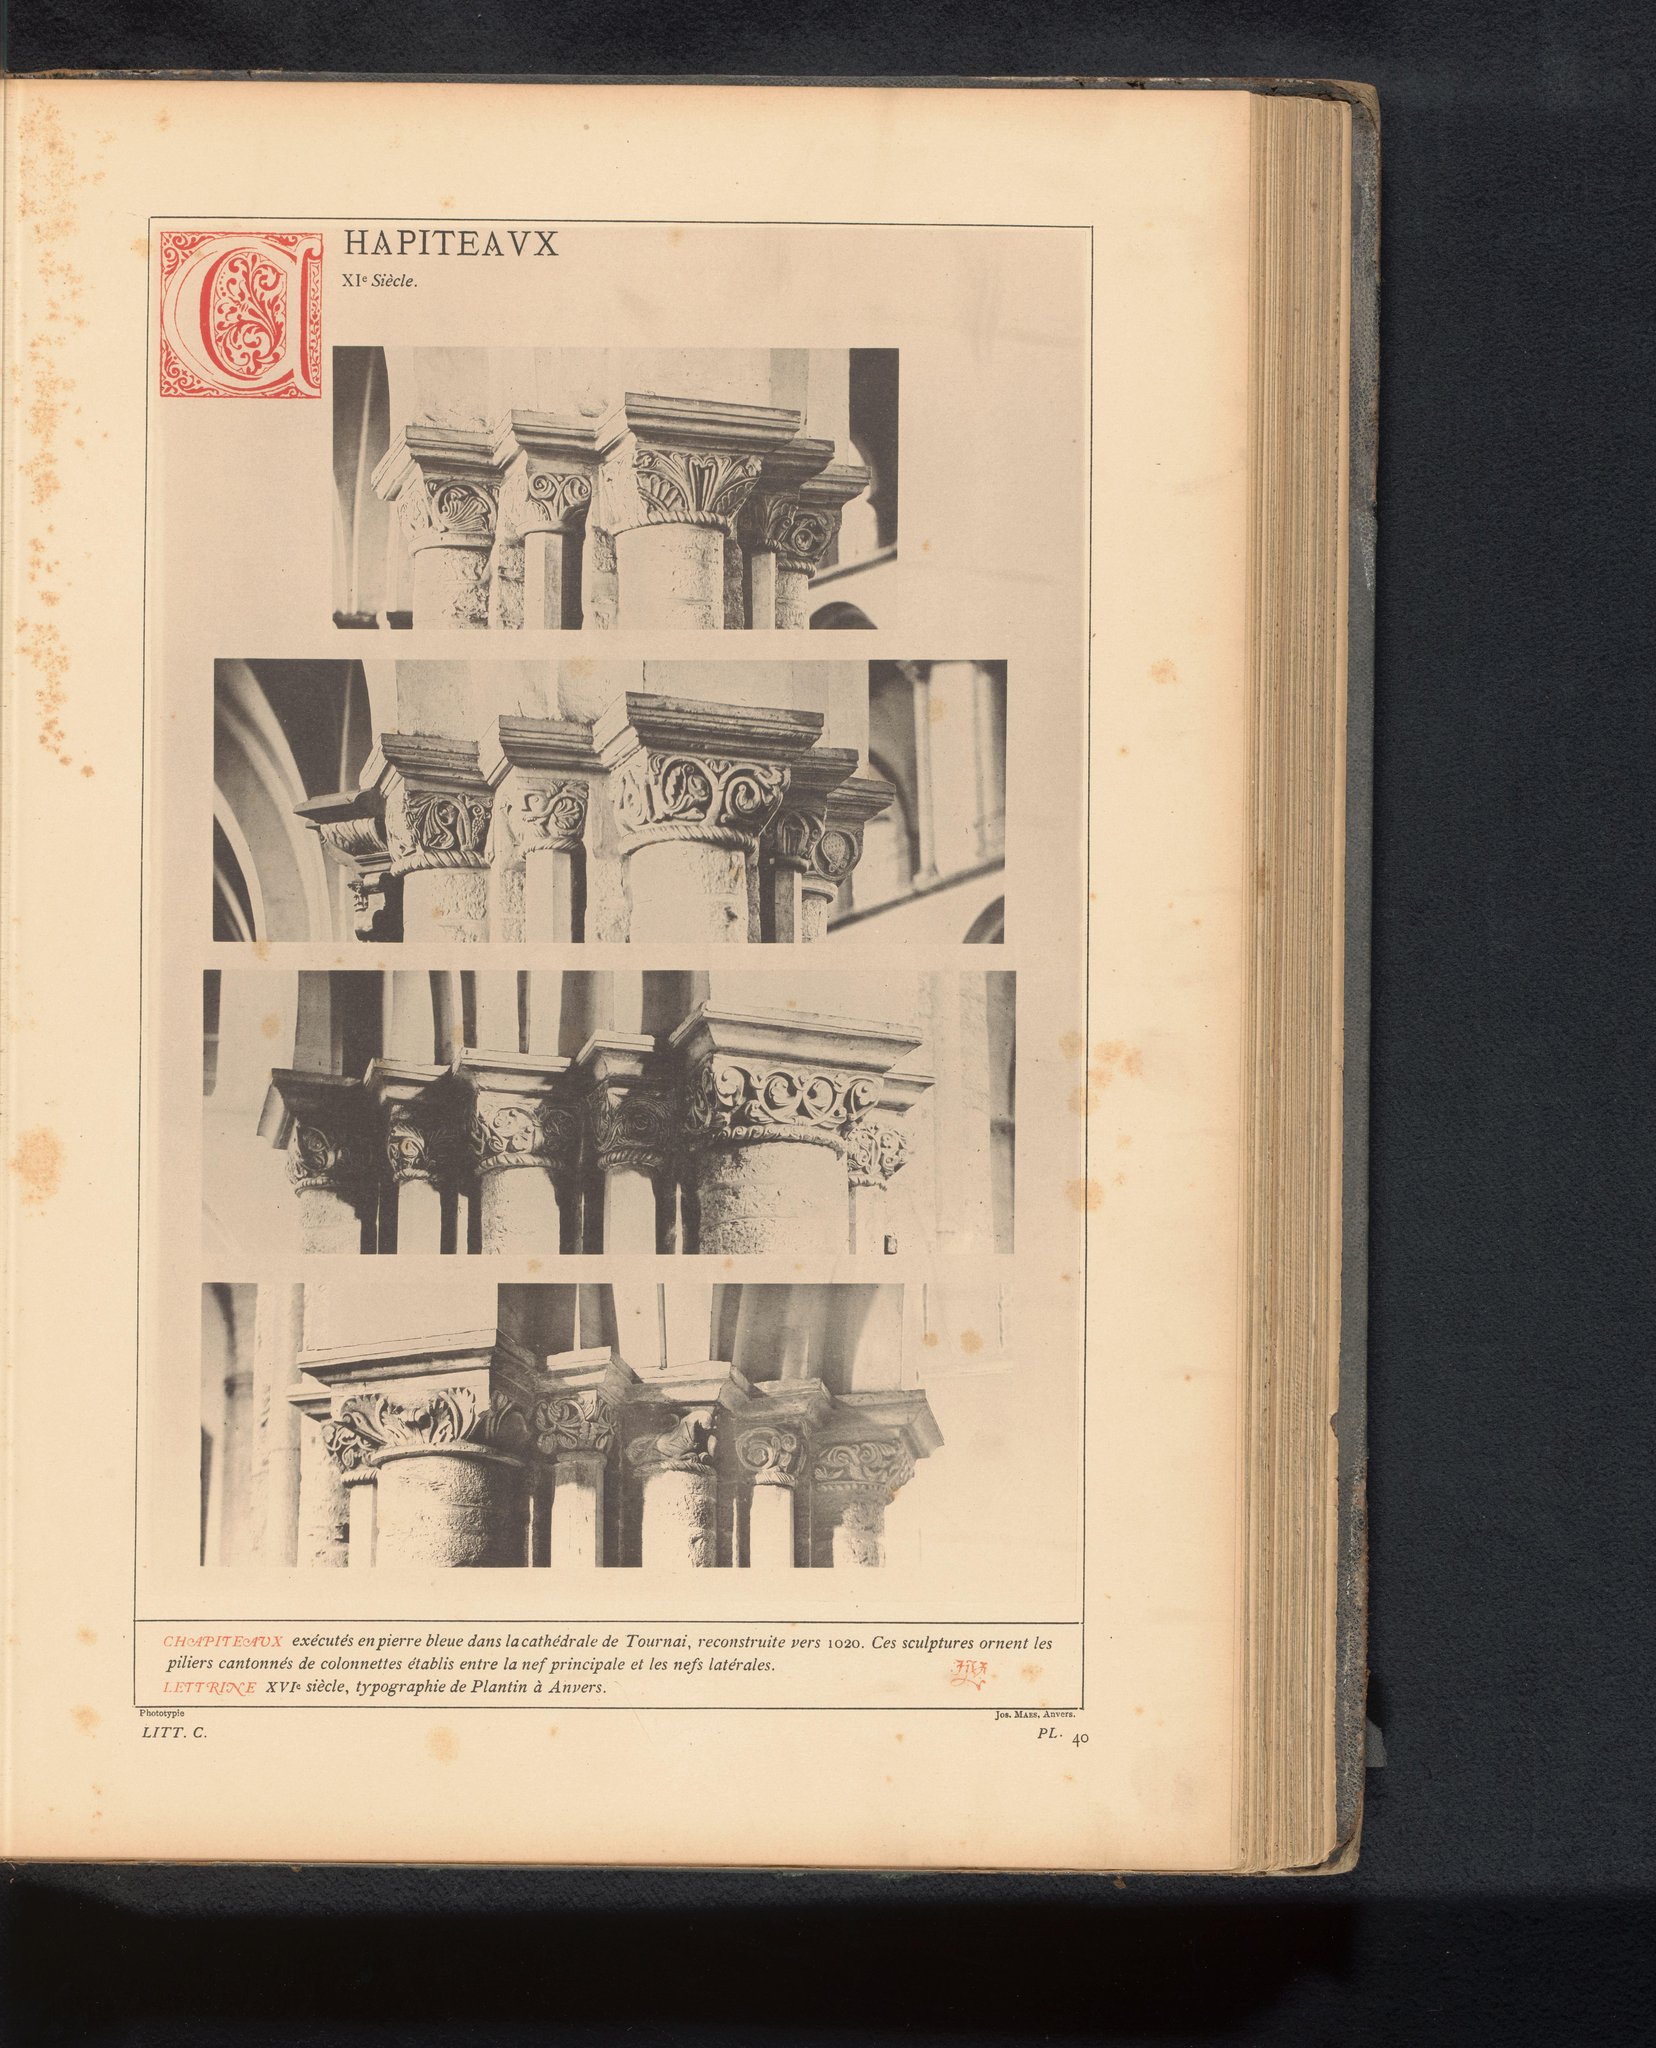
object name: photomechanical print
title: Chapiteaux, XIe Siècle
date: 1875-1880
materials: paper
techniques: photograph, photolithography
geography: antwerp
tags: capital (~ column, pillar)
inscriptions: inscription: ‘LITT. C. - PL. 40’, inscription: ‘Chapiteaux exécutés en (...)’, monogram: ‘JJvY’